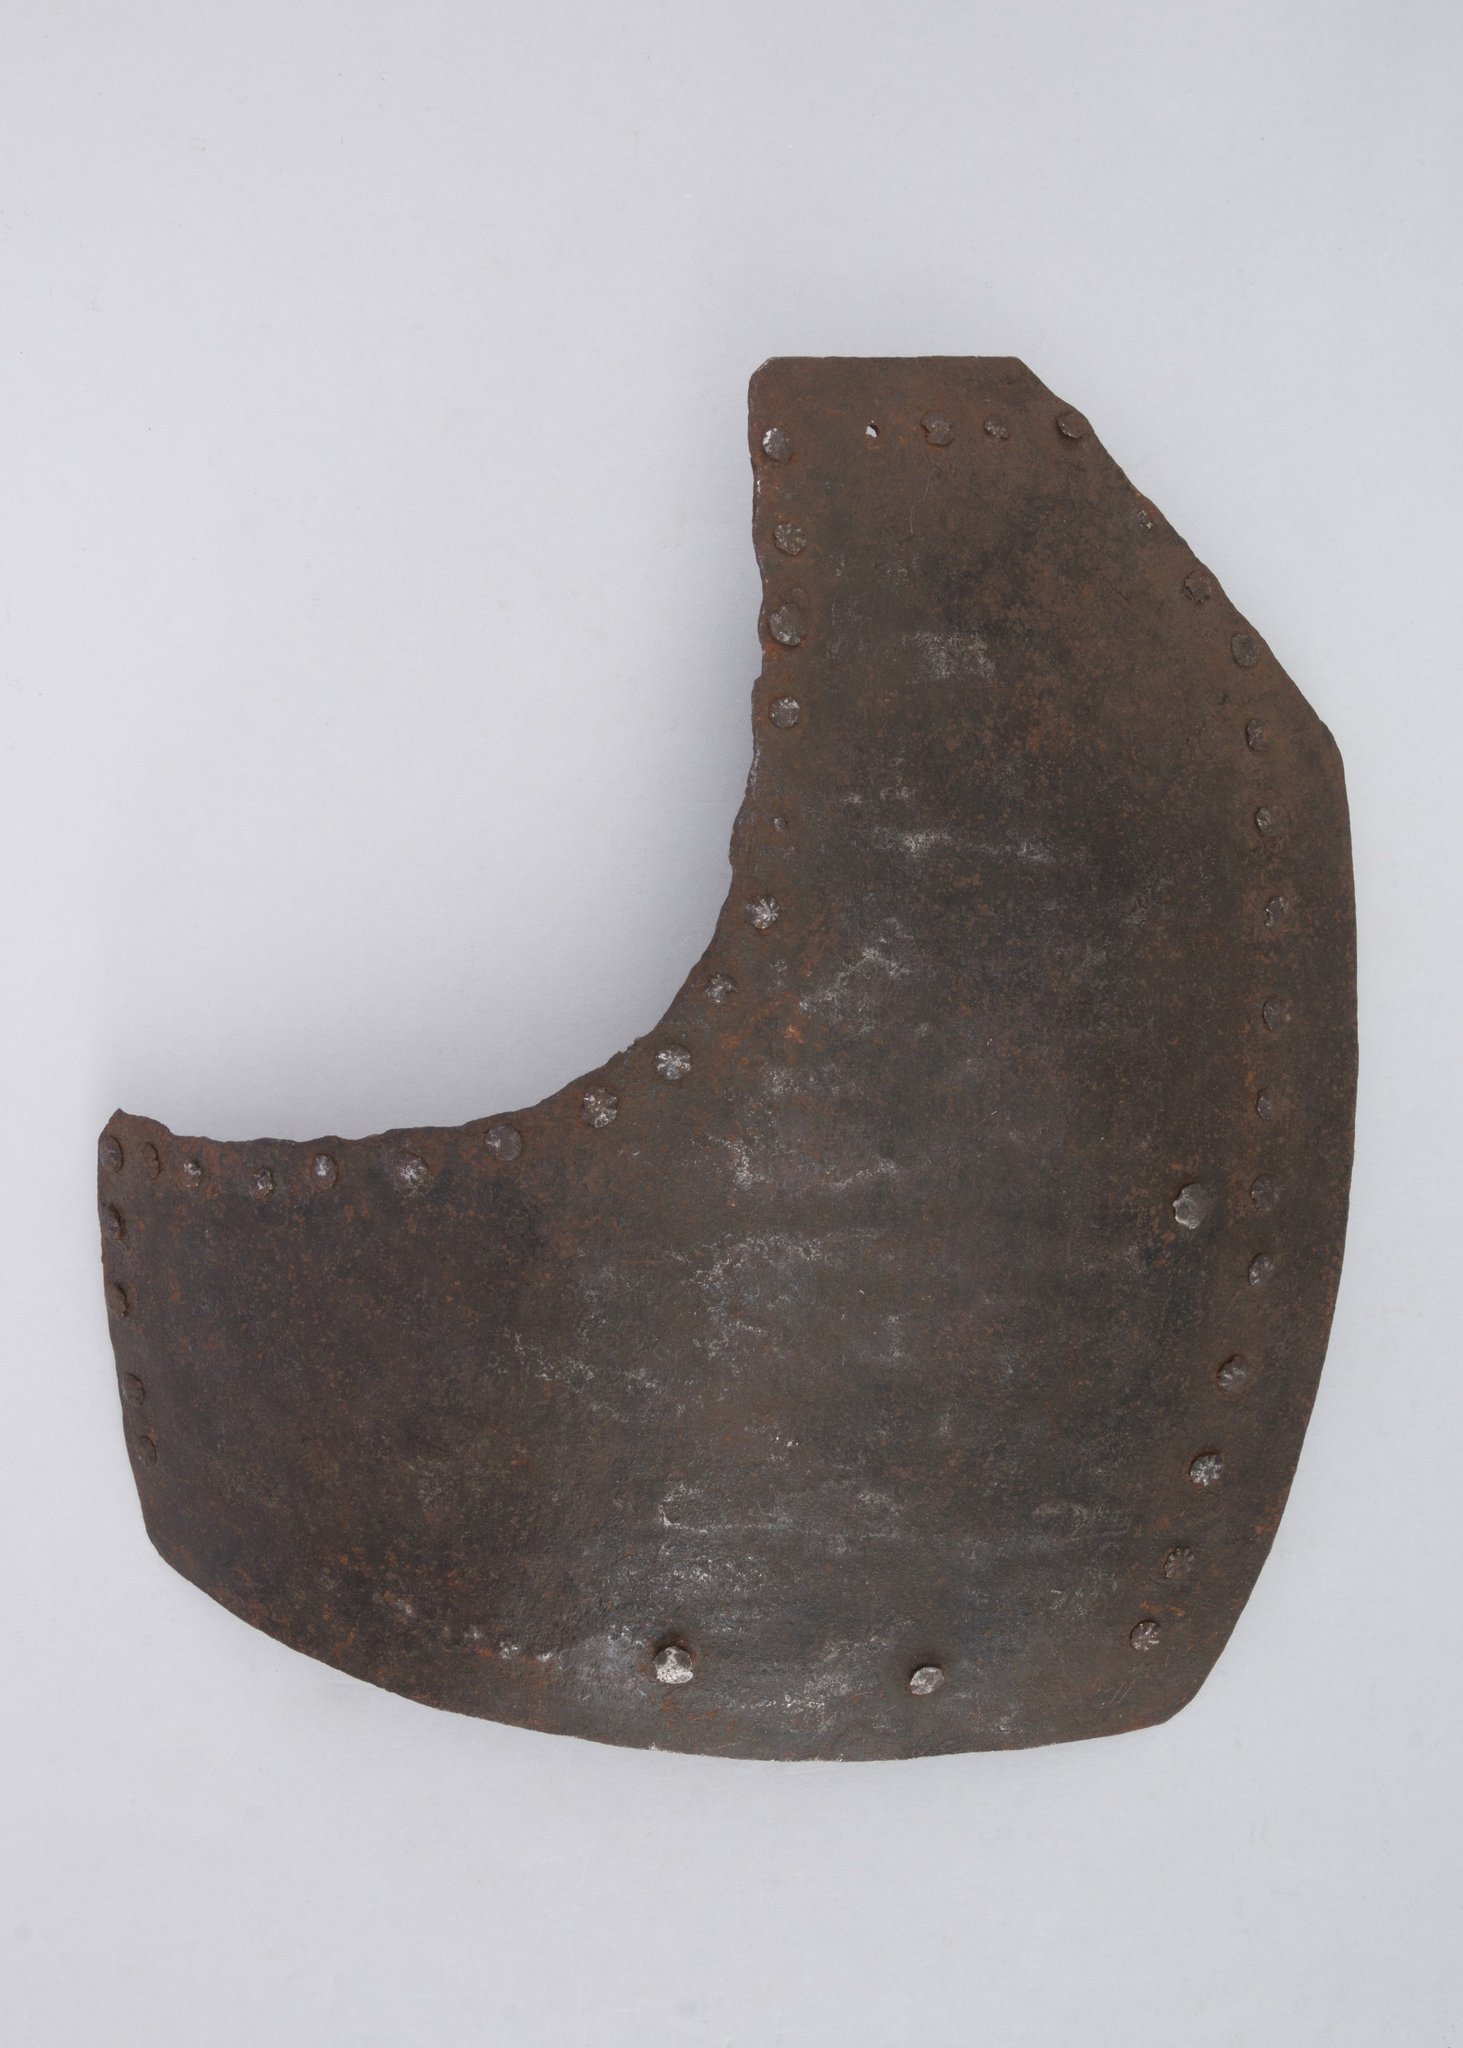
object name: brigandine plate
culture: italian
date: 1400-1450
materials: metal alloy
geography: italy